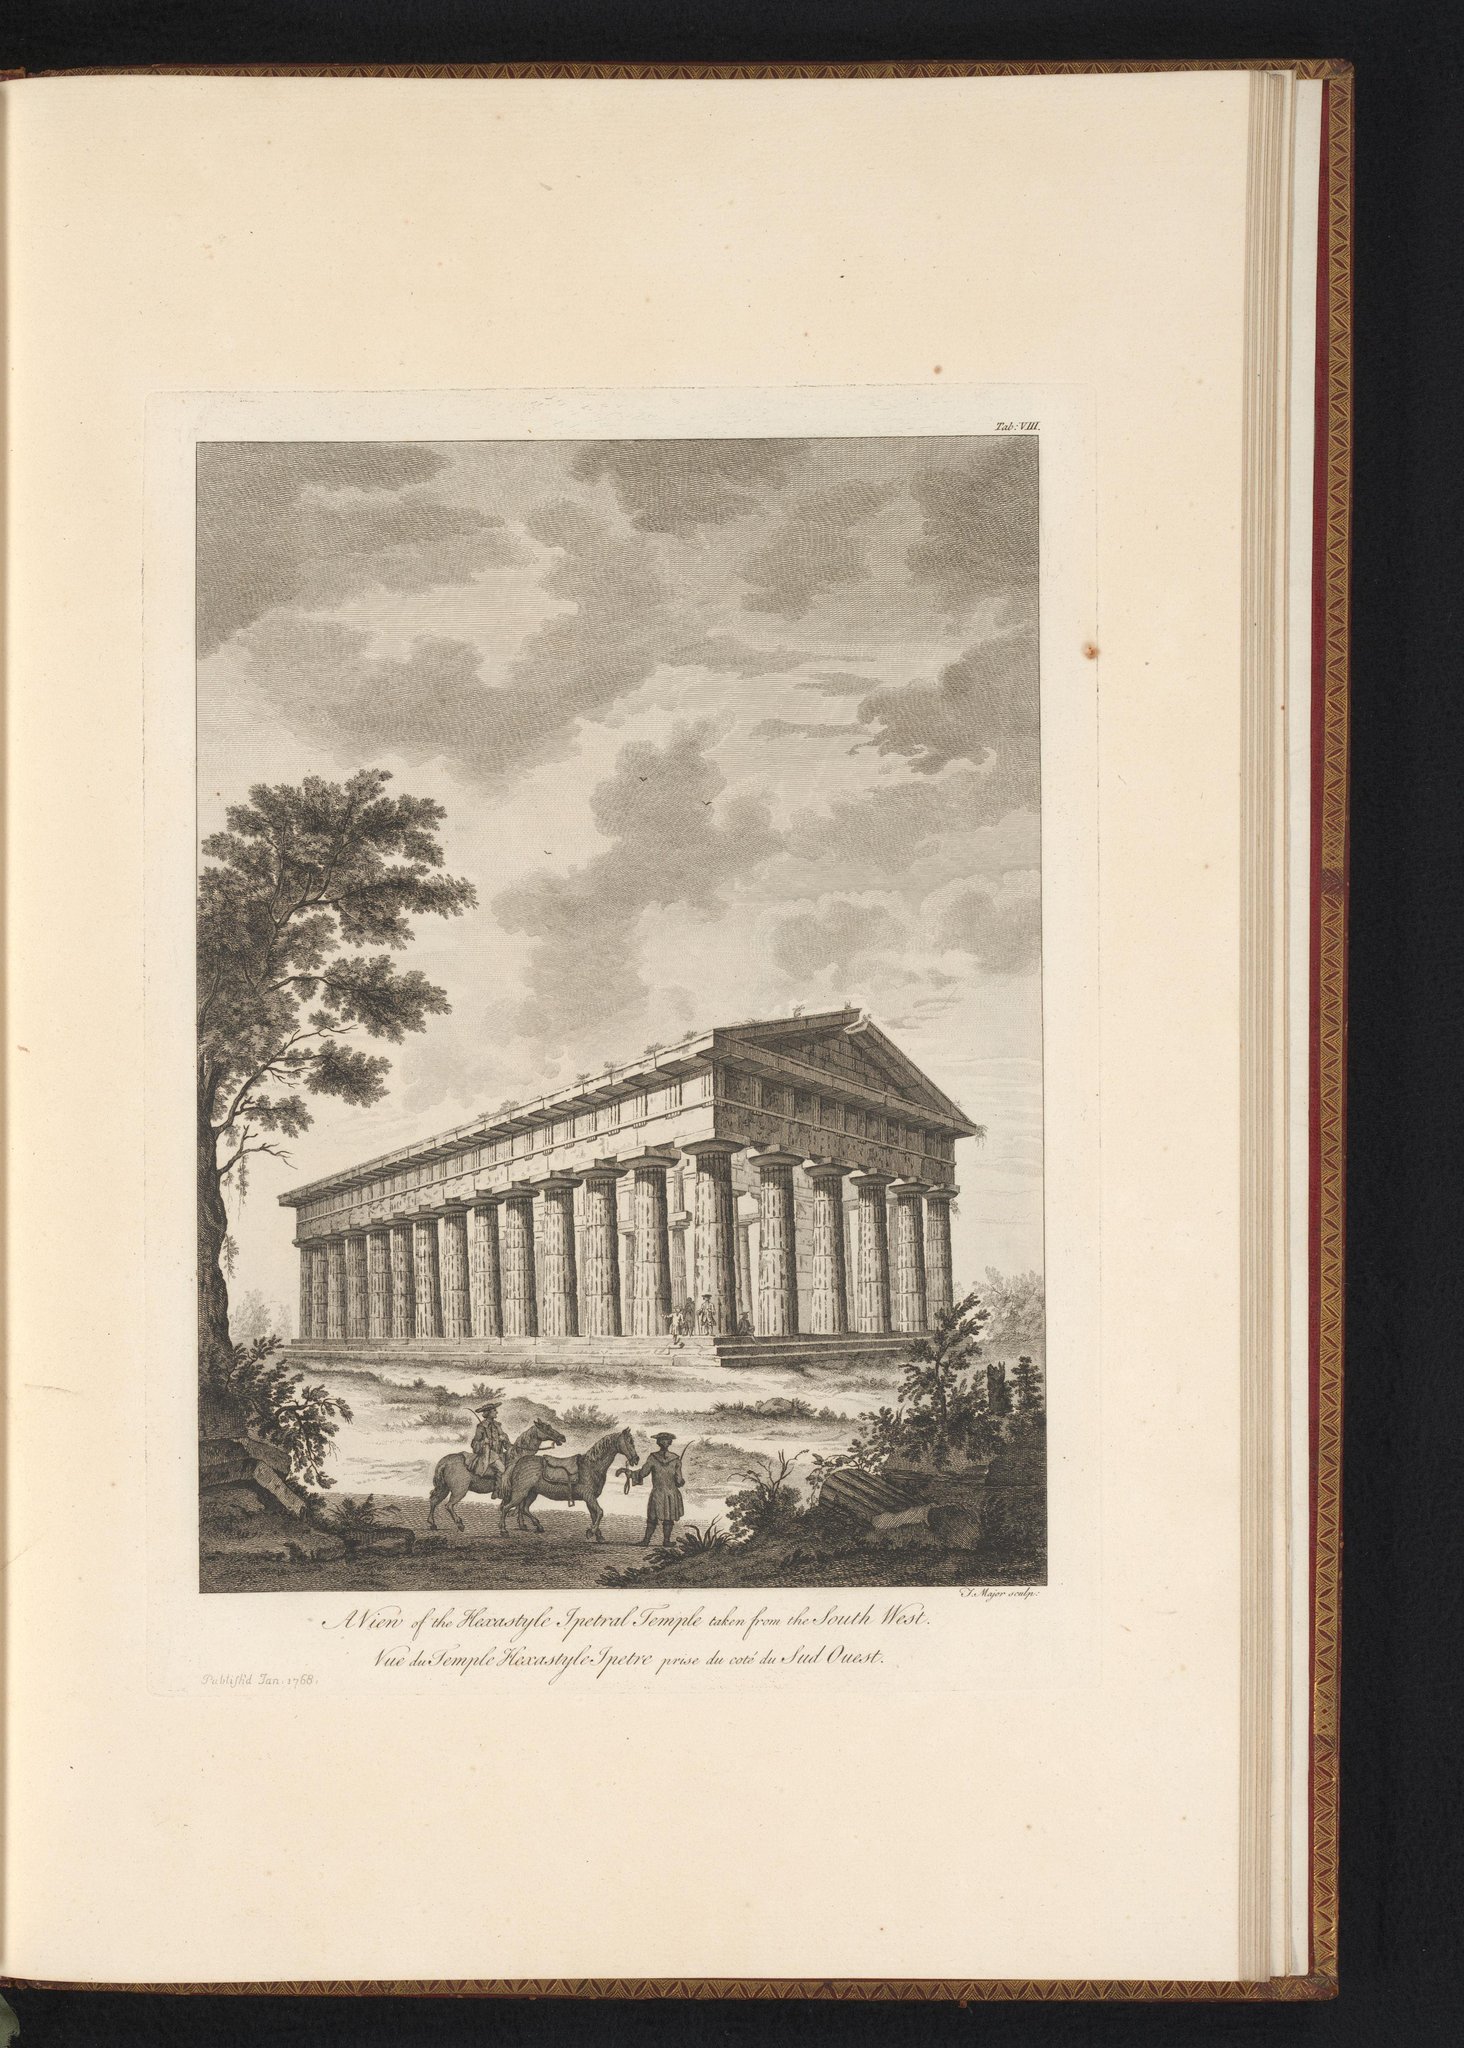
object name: print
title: Zijaanzicht van een ruïne van een tempel in Paestum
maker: thomas major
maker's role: print maker, publisher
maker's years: 1714-1799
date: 1768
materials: paper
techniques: engraving, etching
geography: london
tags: parts of church exterior and annexes: west façade, landscape with ruins (+ city(-scape) with figures, staffage), temple, shrine ~ greek religion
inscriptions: date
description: Deze prent is onderdeel van de reeks van 25 genummerde illustraties in deze uitgave.